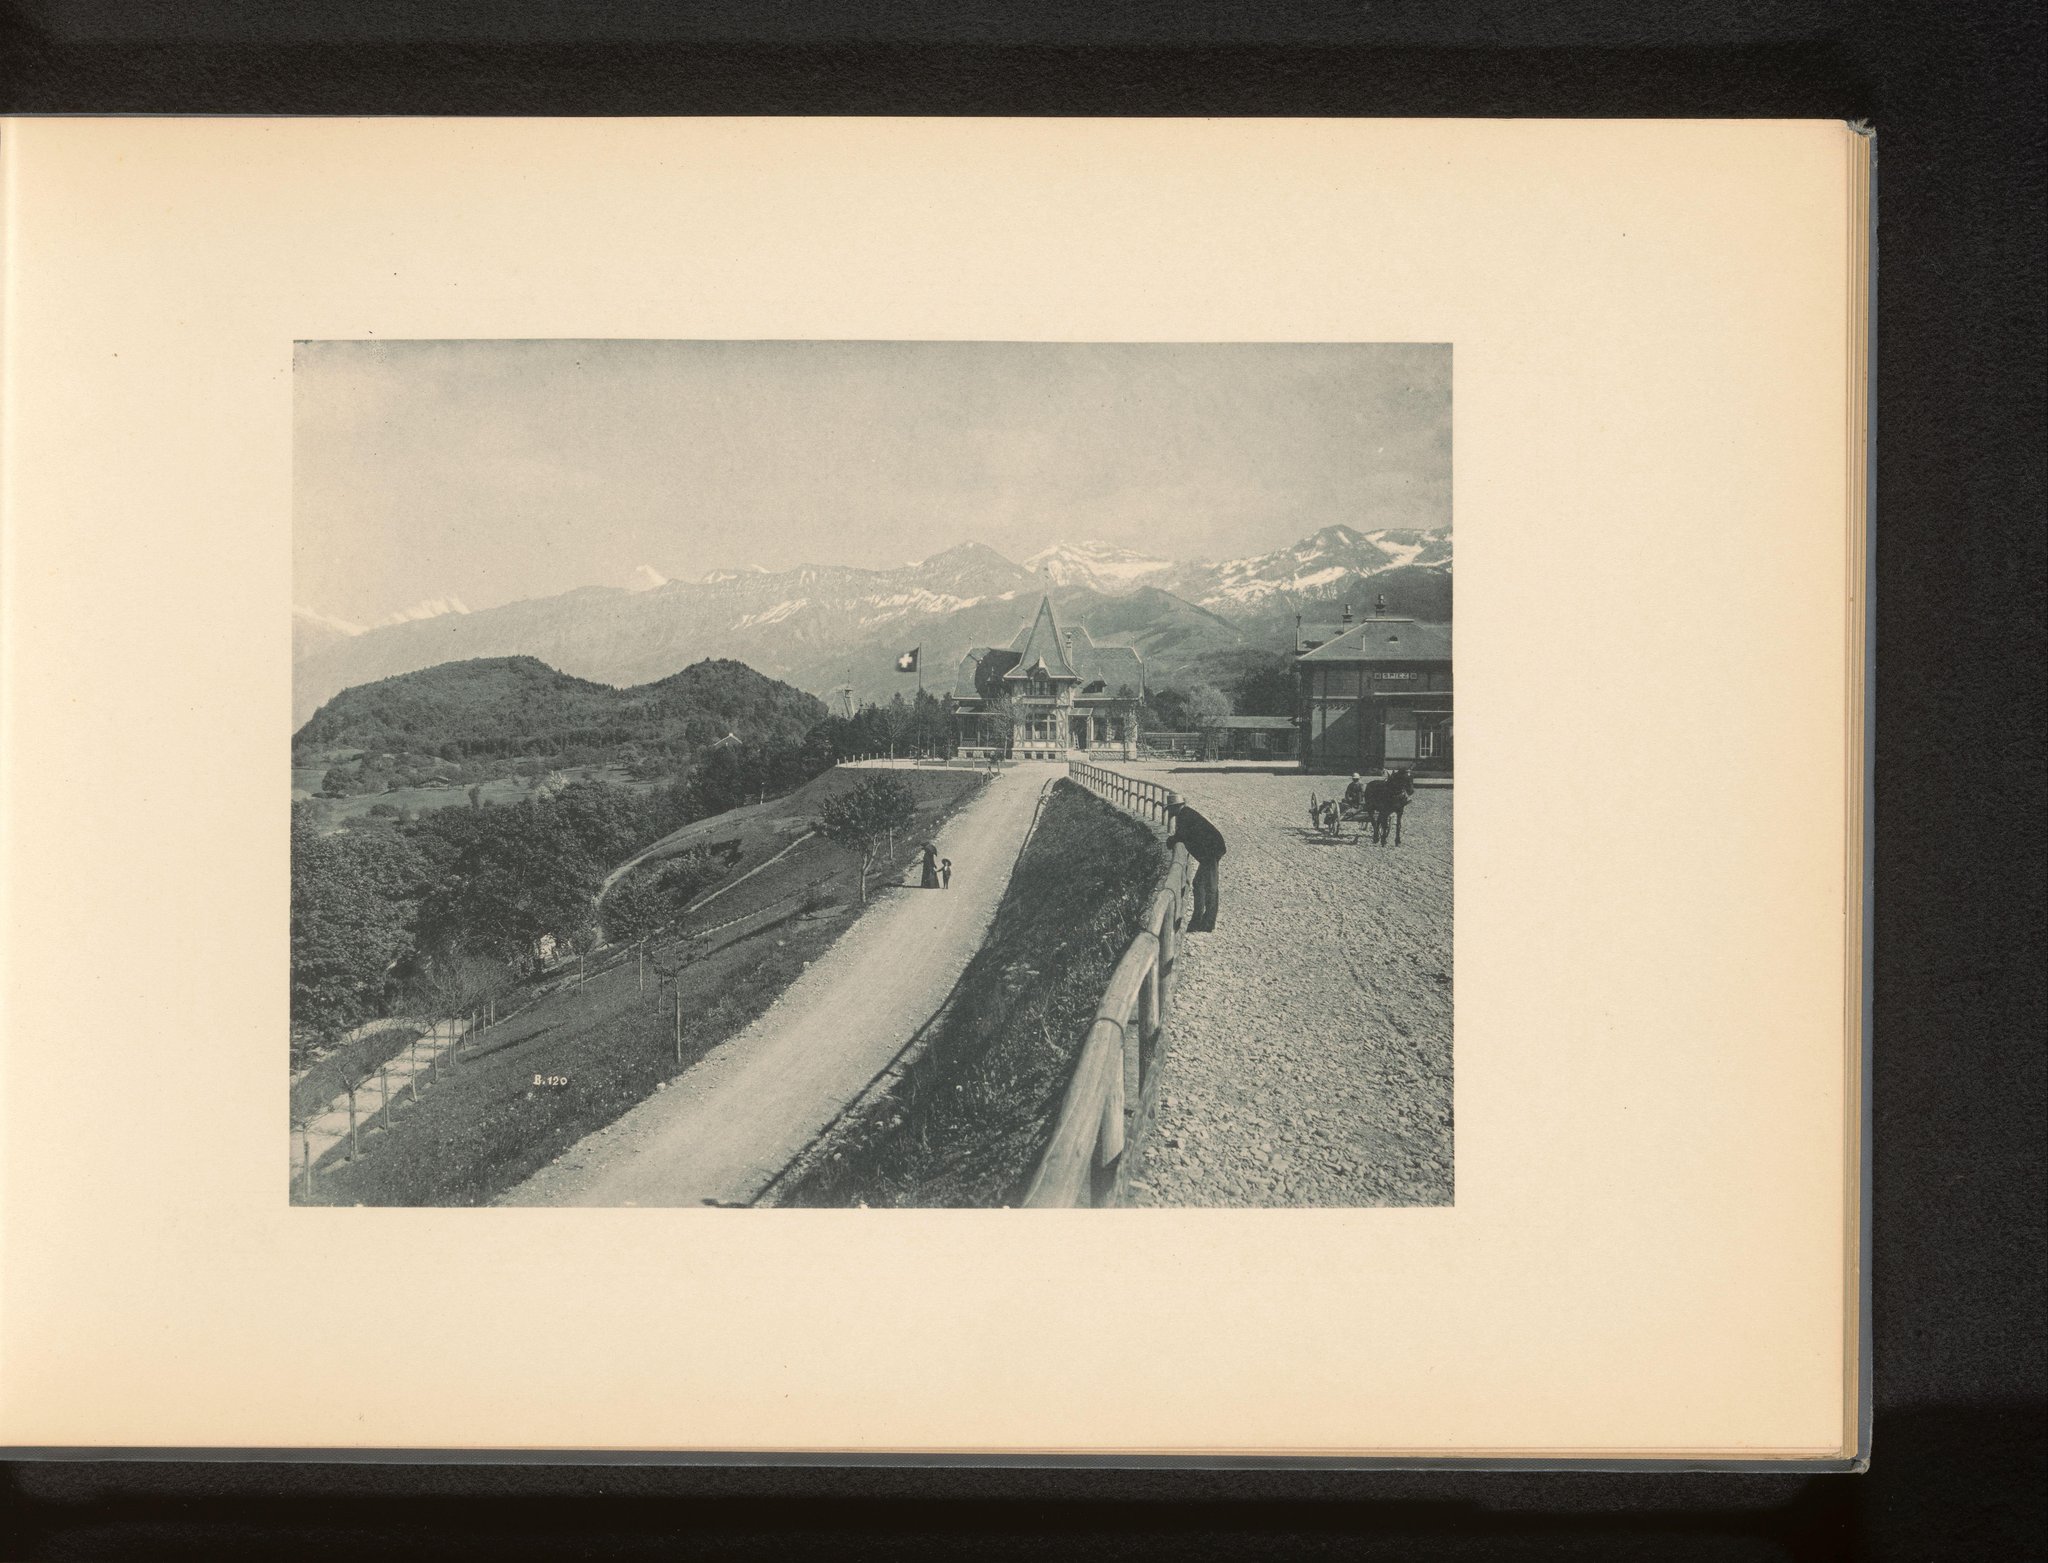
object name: page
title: Gezicht op het station van Spiez, Zwitserland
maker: Anonymous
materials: paper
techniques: photograph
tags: landscape with other man-made constructions not mentioned above, e.g.: graveyards, playgrounds, etc., station; shelter (railway, tramway), mountains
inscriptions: number: ‘B.120’